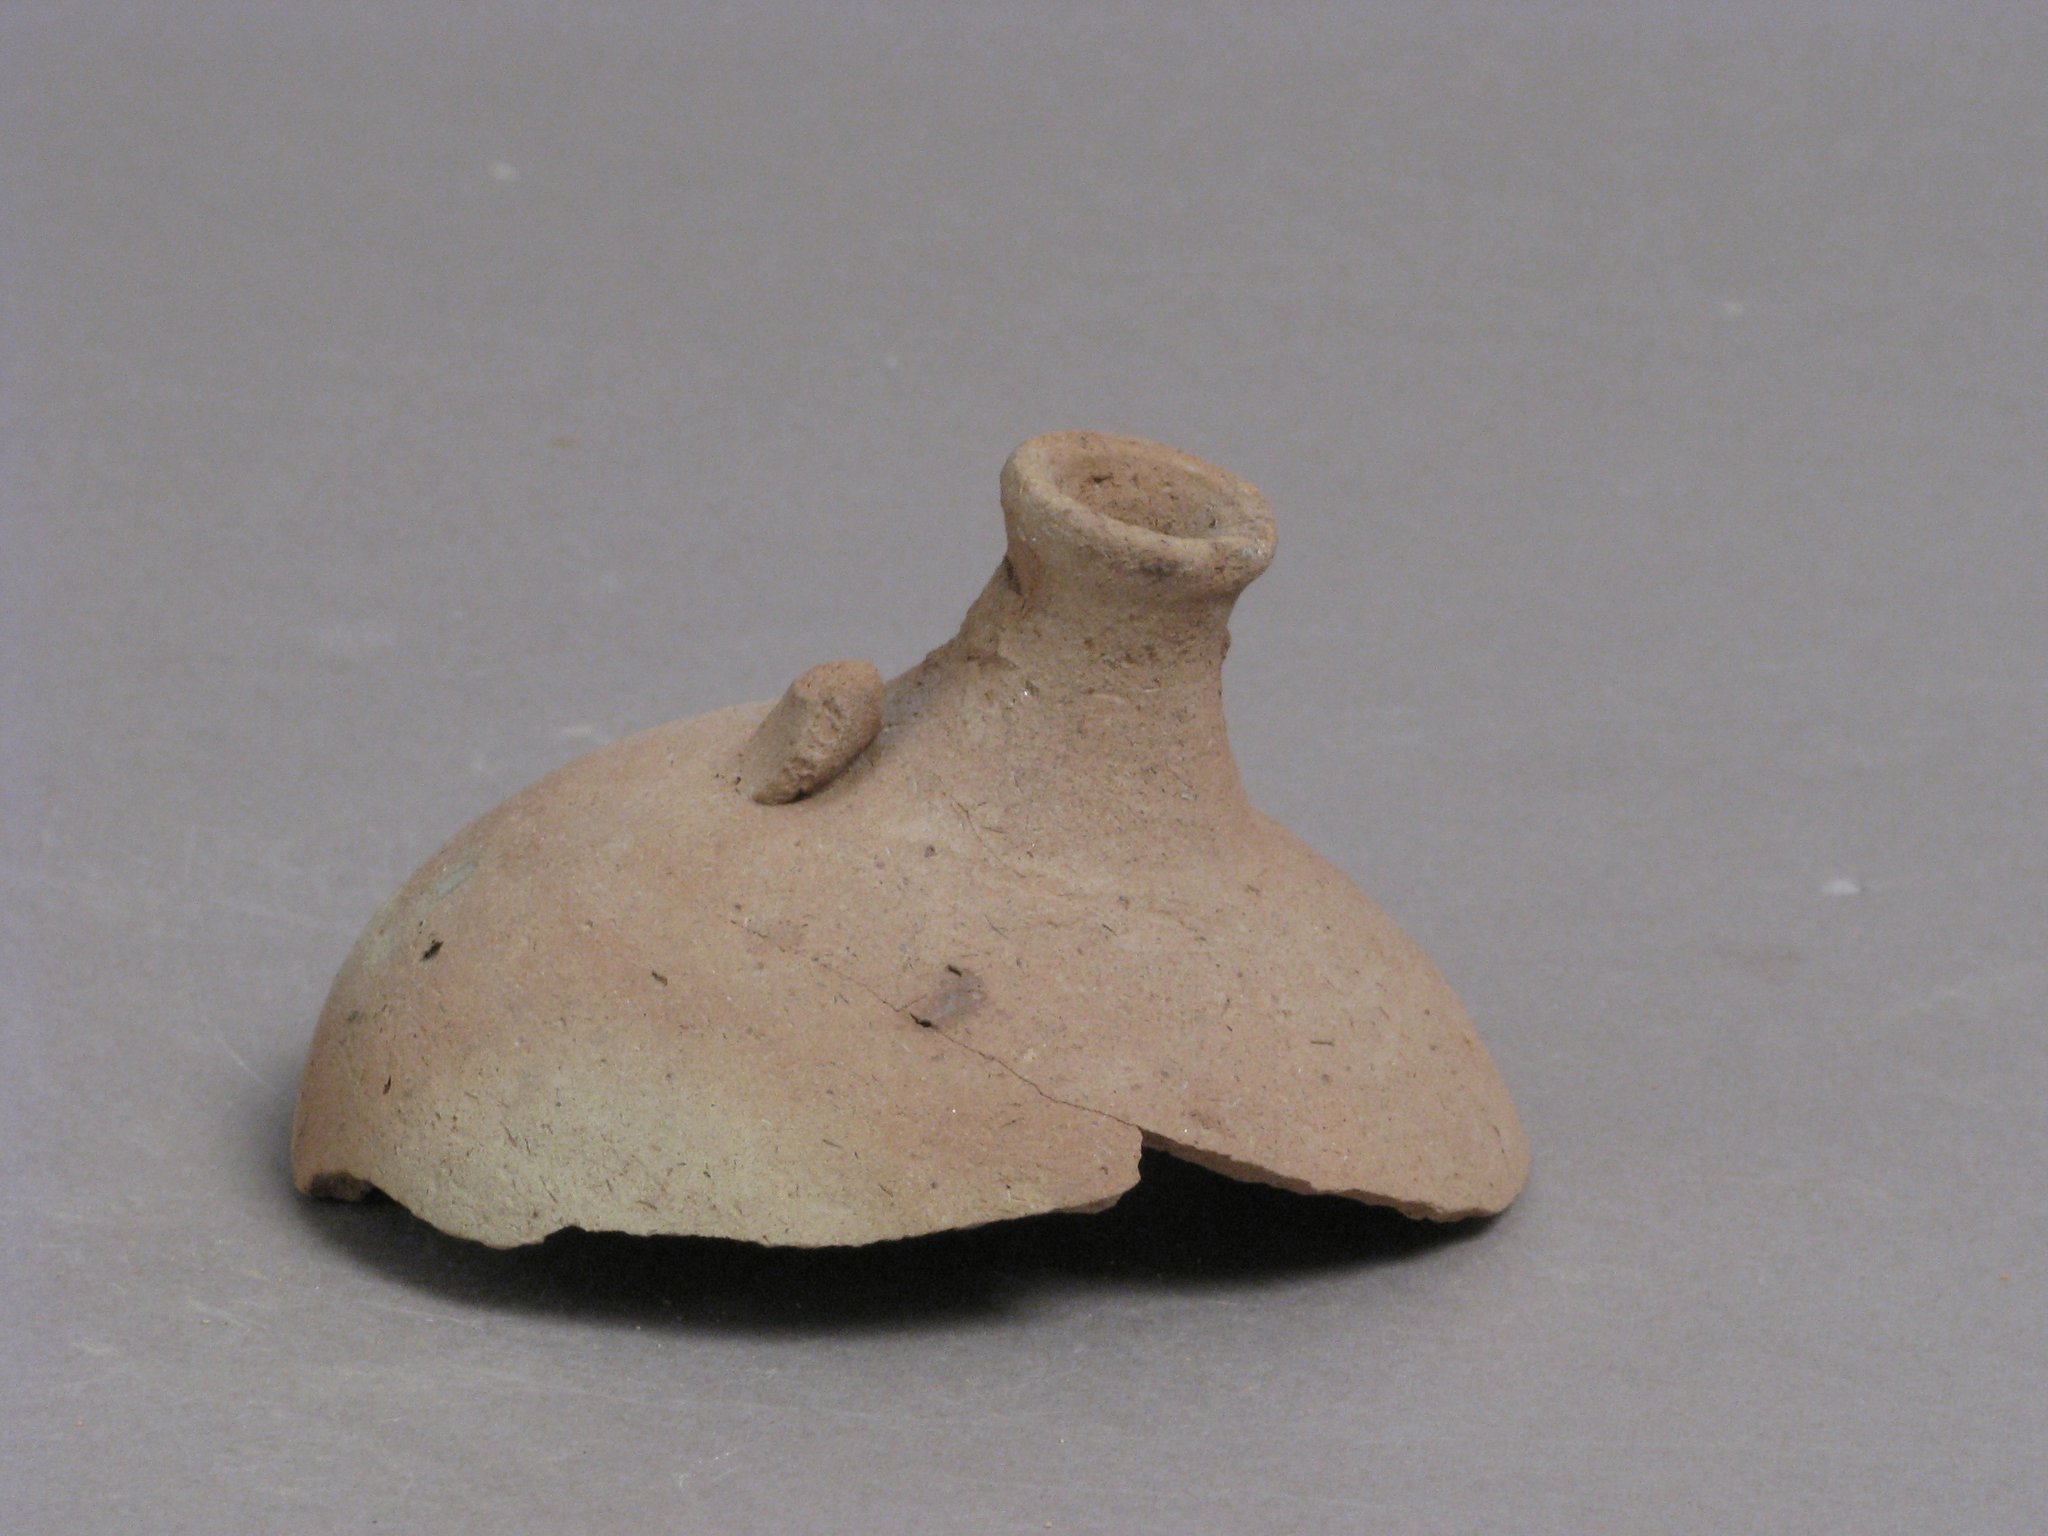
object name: fragment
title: Pot Fragment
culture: coptic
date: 301-700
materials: earthenware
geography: egypt